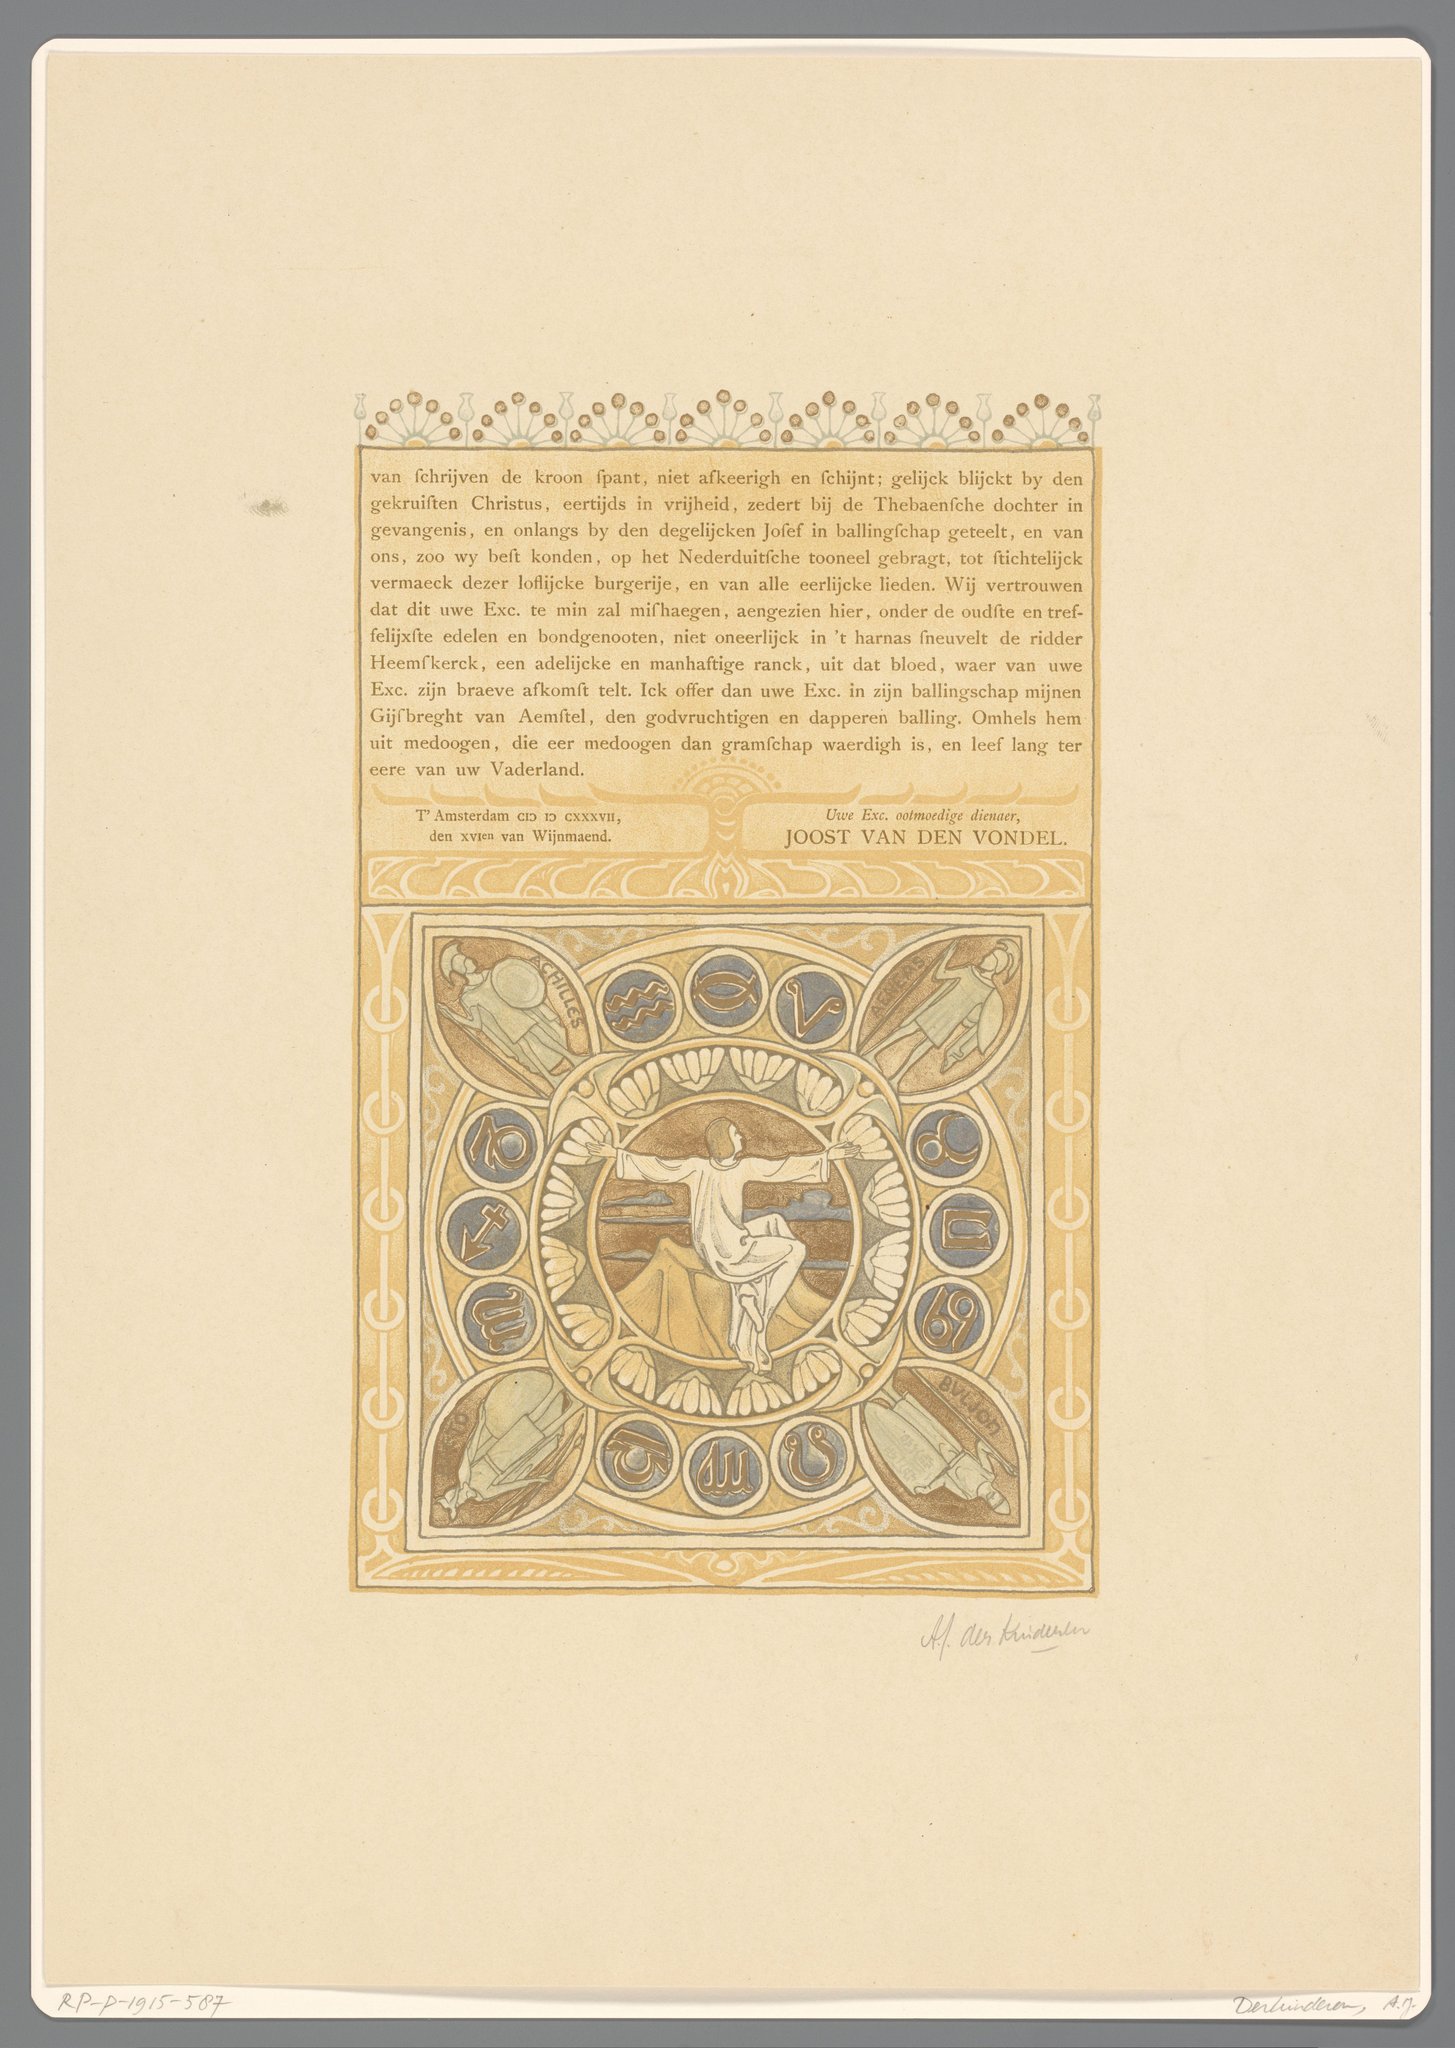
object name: book illustration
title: Opdracht aan Hugo de Groot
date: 1894-1901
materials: paper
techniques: lithograph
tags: arm stretched sidewards (+ expressive connotations), zodiac; the twelve zodiacal signs together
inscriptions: collector's mark: Lugt 2233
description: Bovenaan tekst. Daaronder een figuur met gestrekte armen zittend op een berg, omgeven door een cirkel die versierd is met bloemmotieven. Om deze cirkel dierenriemtekens en beeltenissen van Aeneas, Buljon, Baeto en Achilles. Om het geheel een rechthoekig kader dat versierd is met bloem- en plantmotieven. Derde pagina.